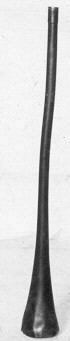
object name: metal tube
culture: belgian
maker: victor-charles mahillon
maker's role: maker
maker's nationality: belgian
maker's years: 1841-1924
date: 1867-1900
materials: metal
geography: belgium